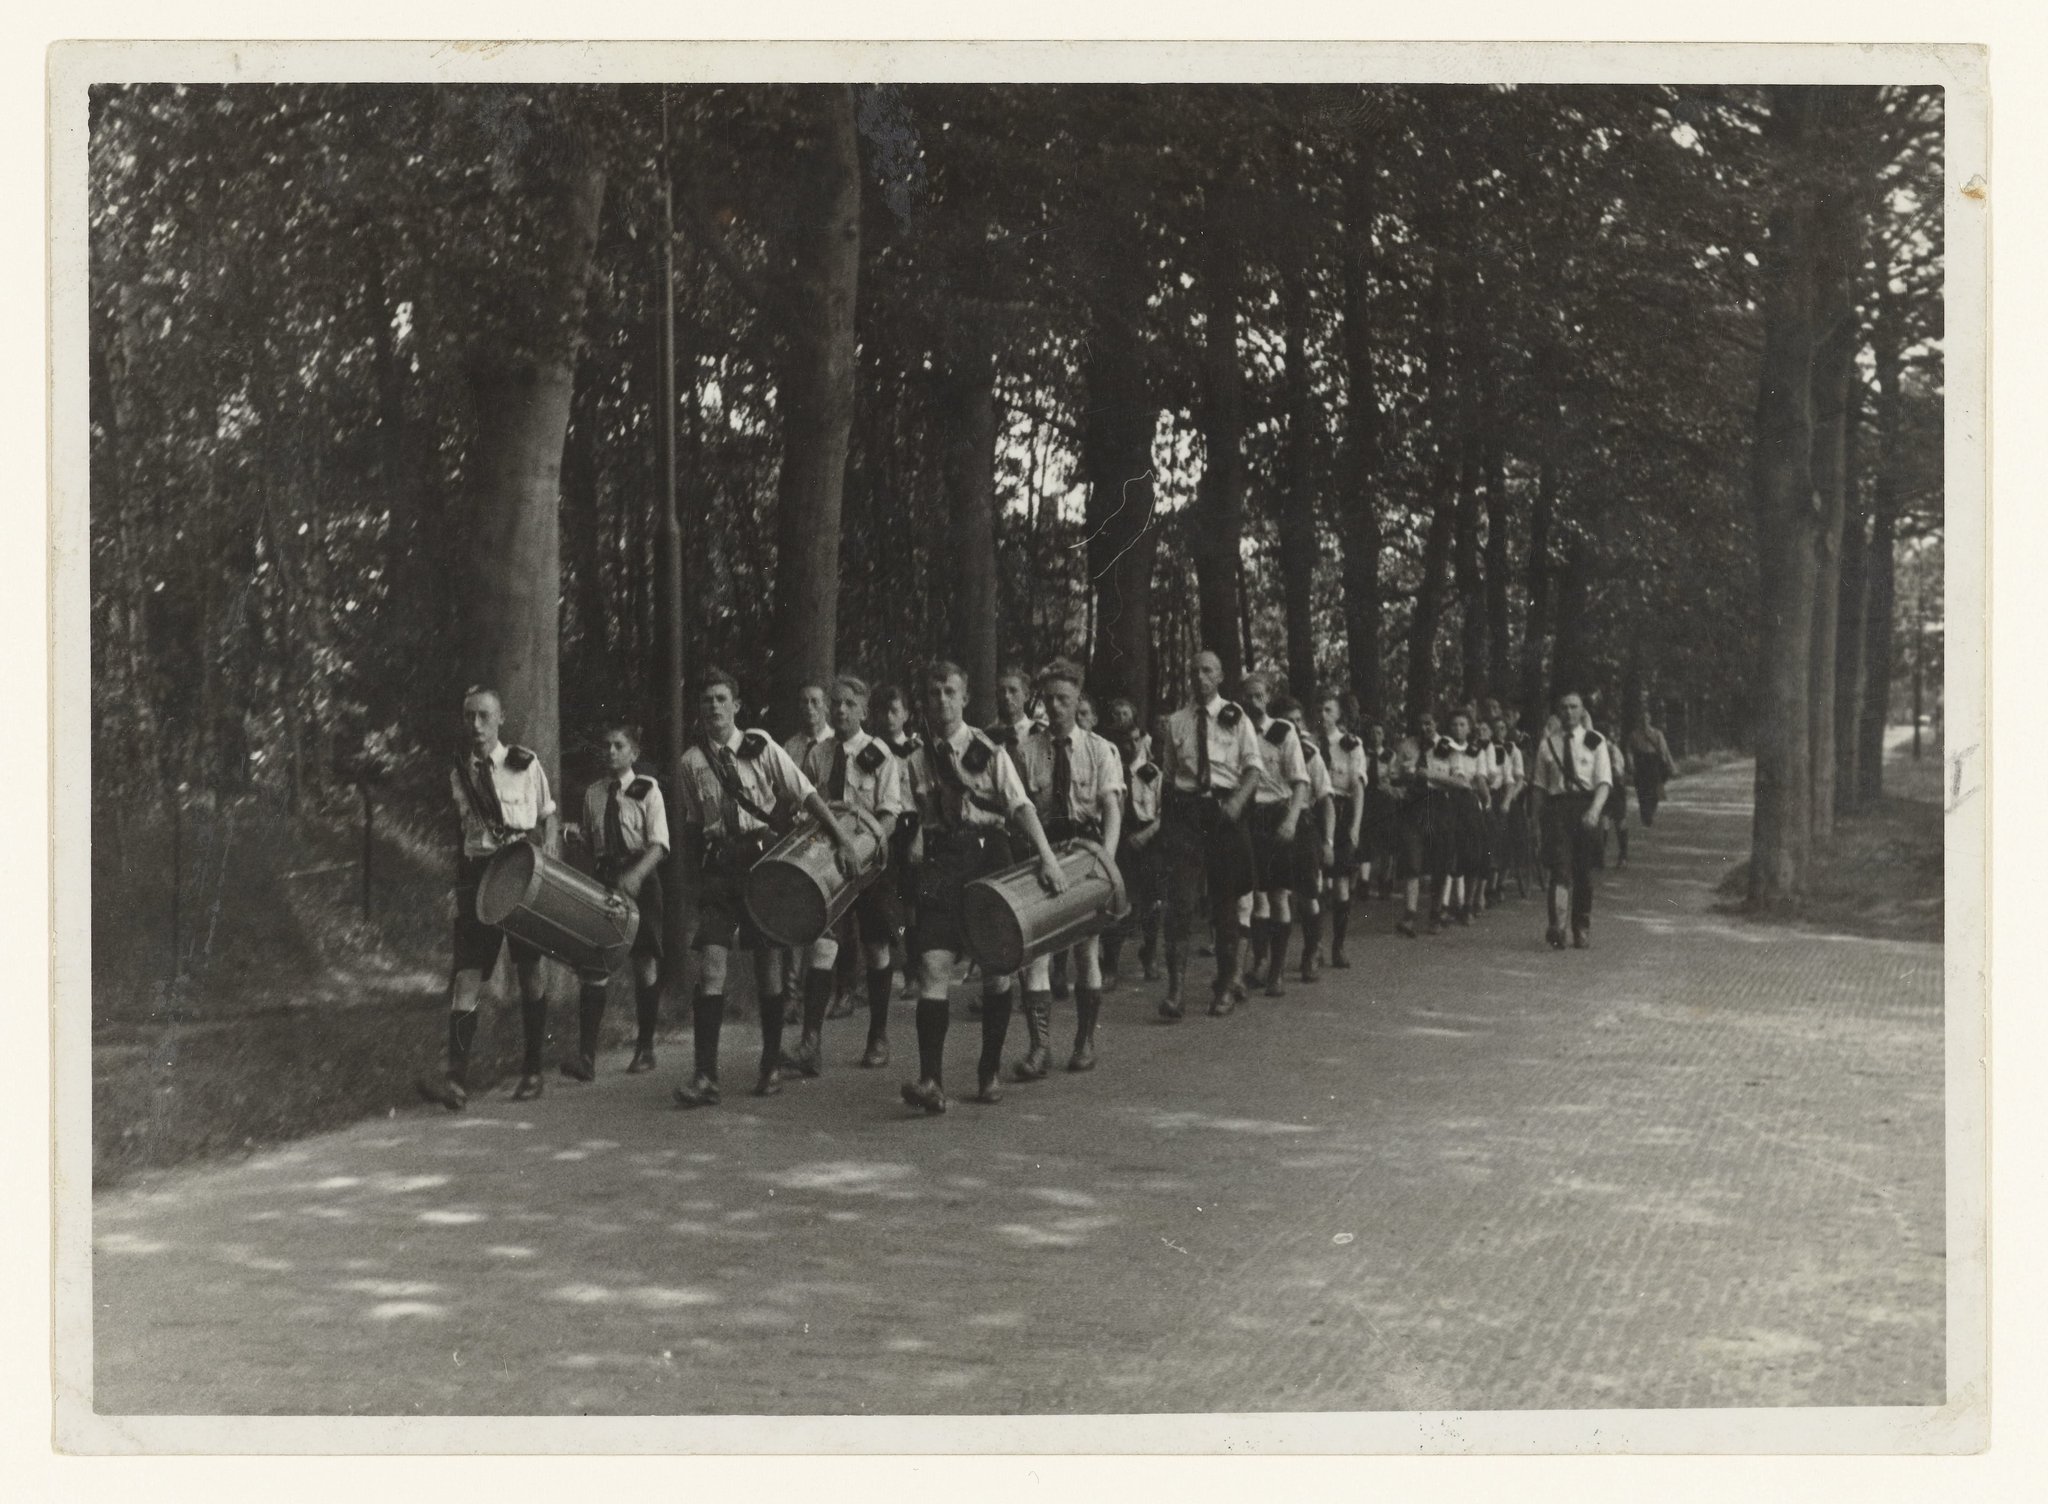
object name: photograph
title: Jeugdstormers marcheren door een bos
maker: Anonymous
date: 1934-1944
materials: photographic support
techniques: photography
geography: netherlands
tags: military parade, pageant, netherlands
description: Een groep jongens en meisjes, met volwassen begeleiders, in het uniform van de (Nationale) Jeugdstorm lopen in rijen van drie door een bos op een klinkerweg. Voorop drie jongens met trommels.